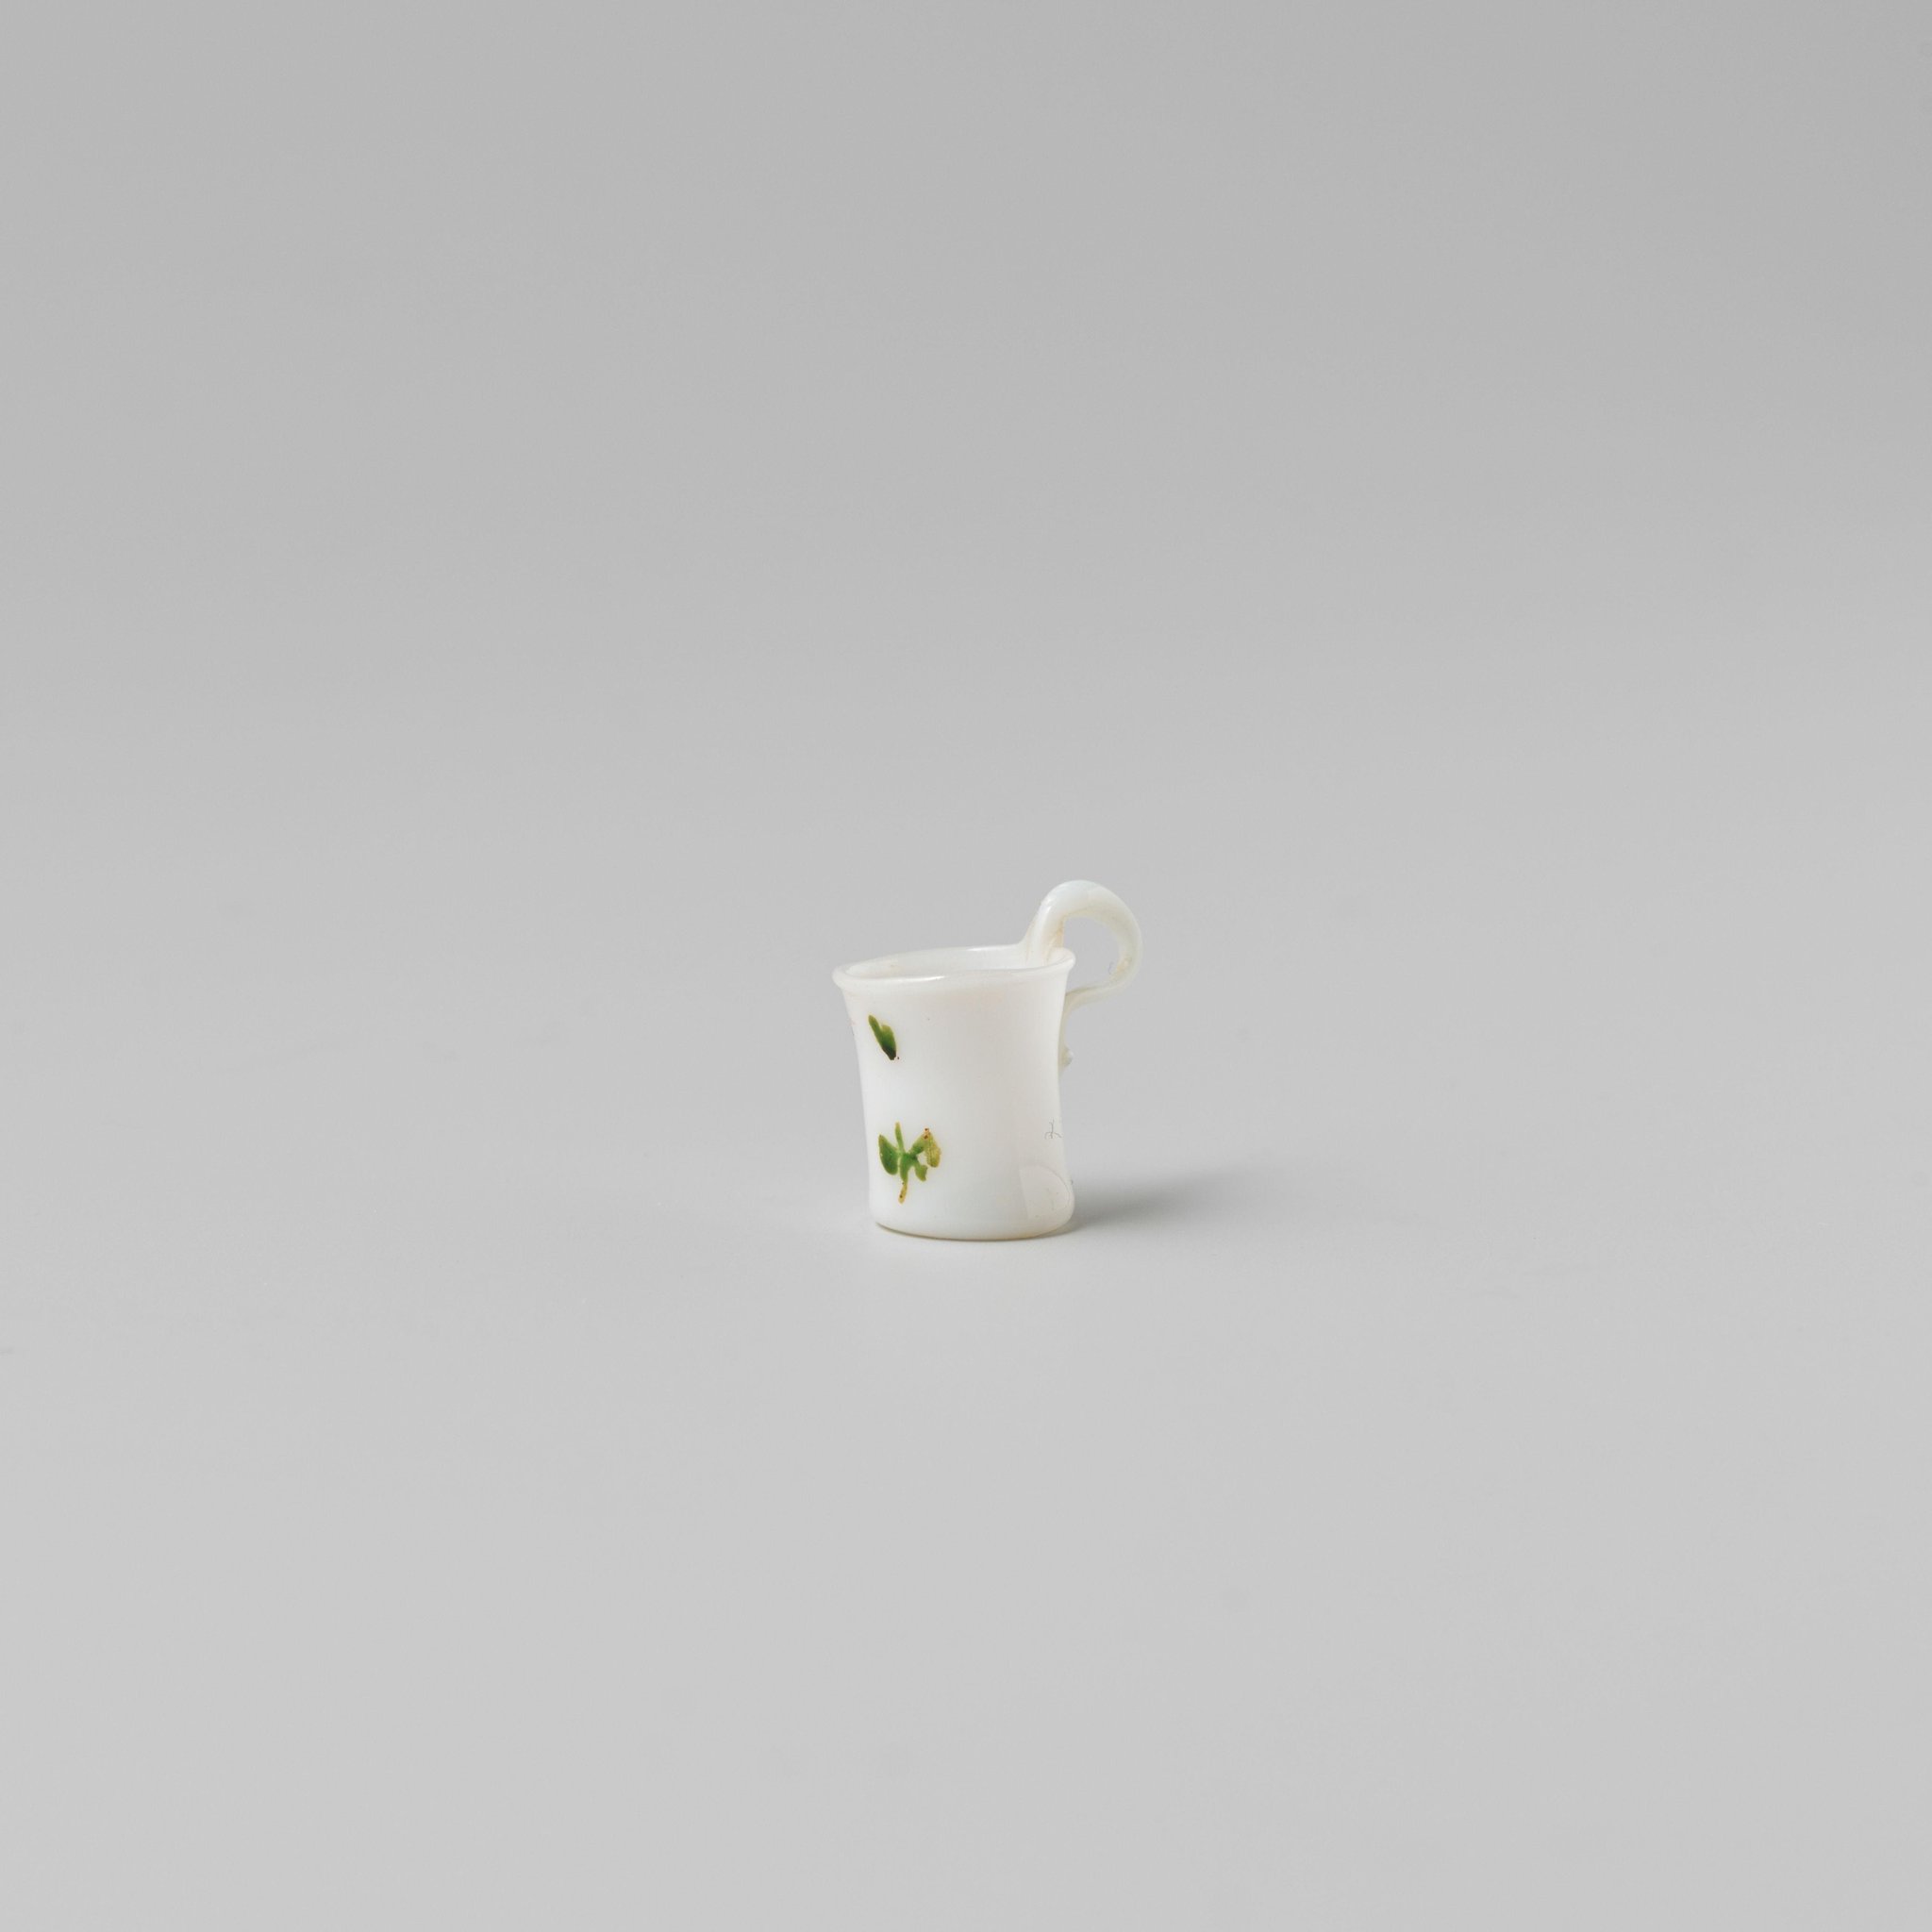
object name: cup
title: Kop met oor, beschilderd met bloem in wit, rood en groen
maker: Anonymous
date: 1800-1849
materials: glass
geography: bristol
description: Kop van opaak wit glas, cilindrisch, met s-vormig oor. De kop is beschilderd met een bloem in wit, rood en groen.